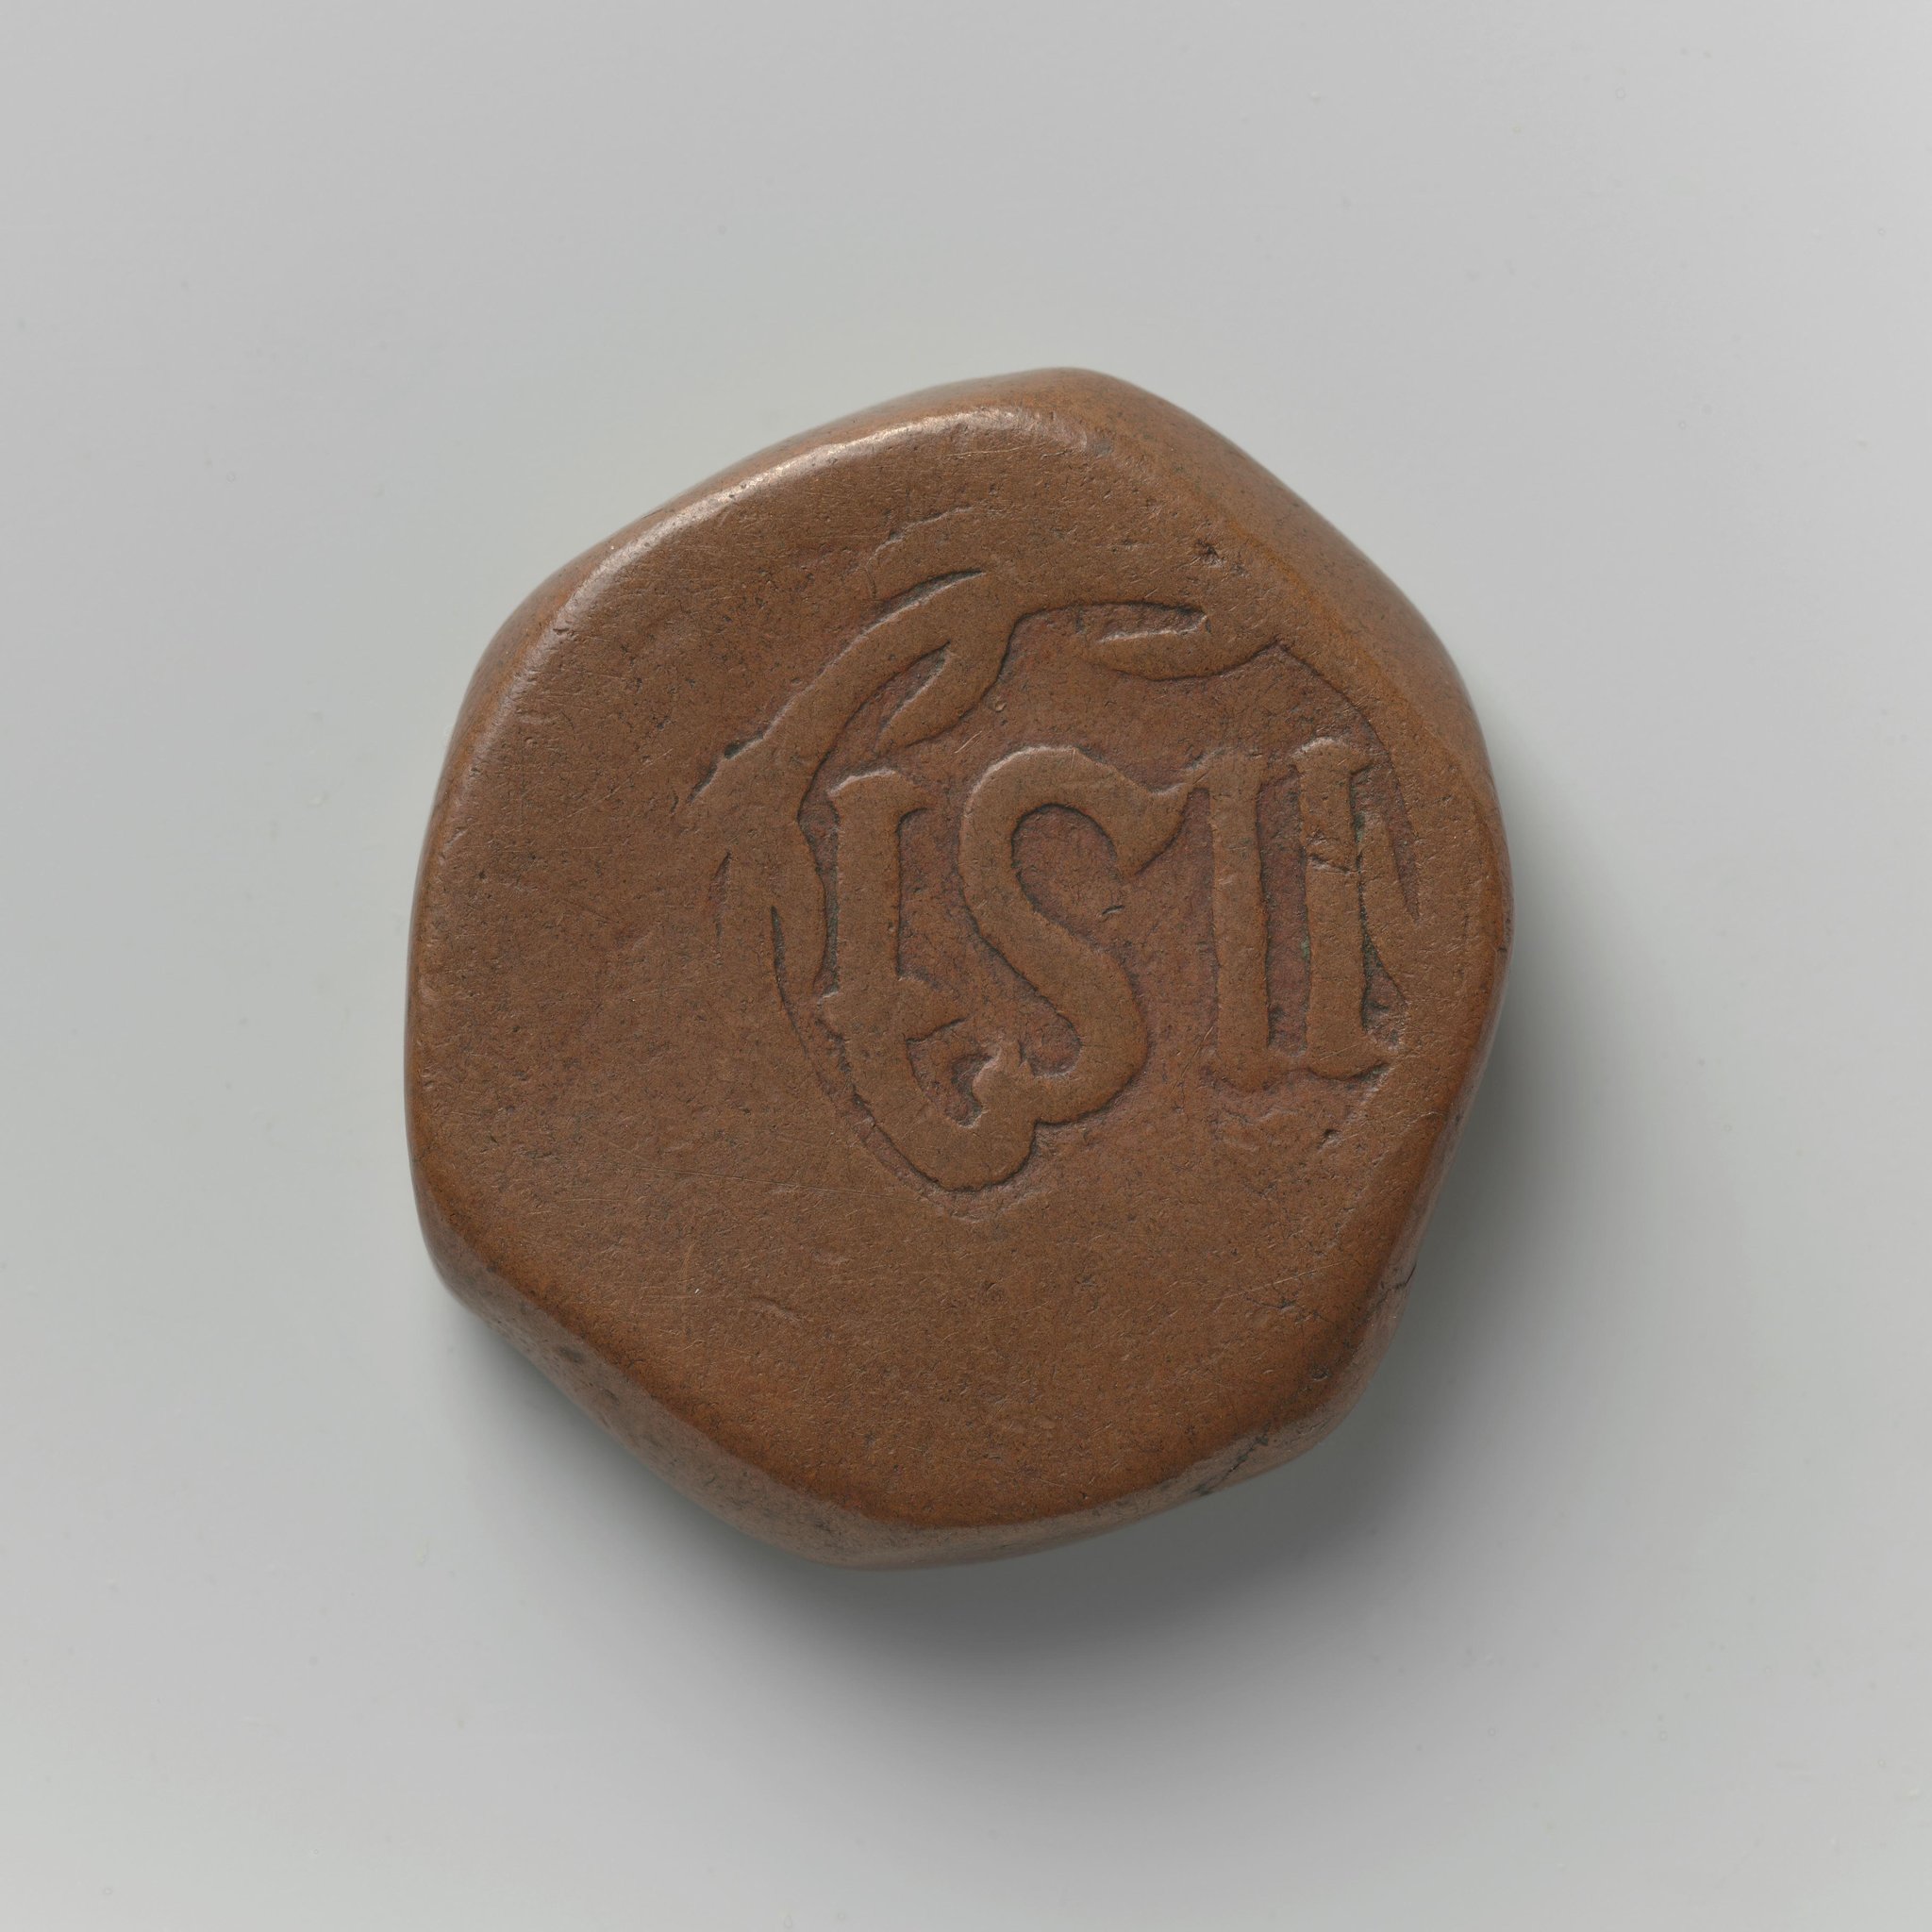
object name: coin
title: Ceylon, 2 kransstuiver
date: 1670-1700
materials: copper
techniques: striking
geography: colombo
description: Koperen munt. Voorzijde: in een bladerkrans waarde-aanduiding II St (t omgekeerd). Keerzijde: in een bladerkrans waarde-aanduiding II St (t omgekeerd). Gladde rand.